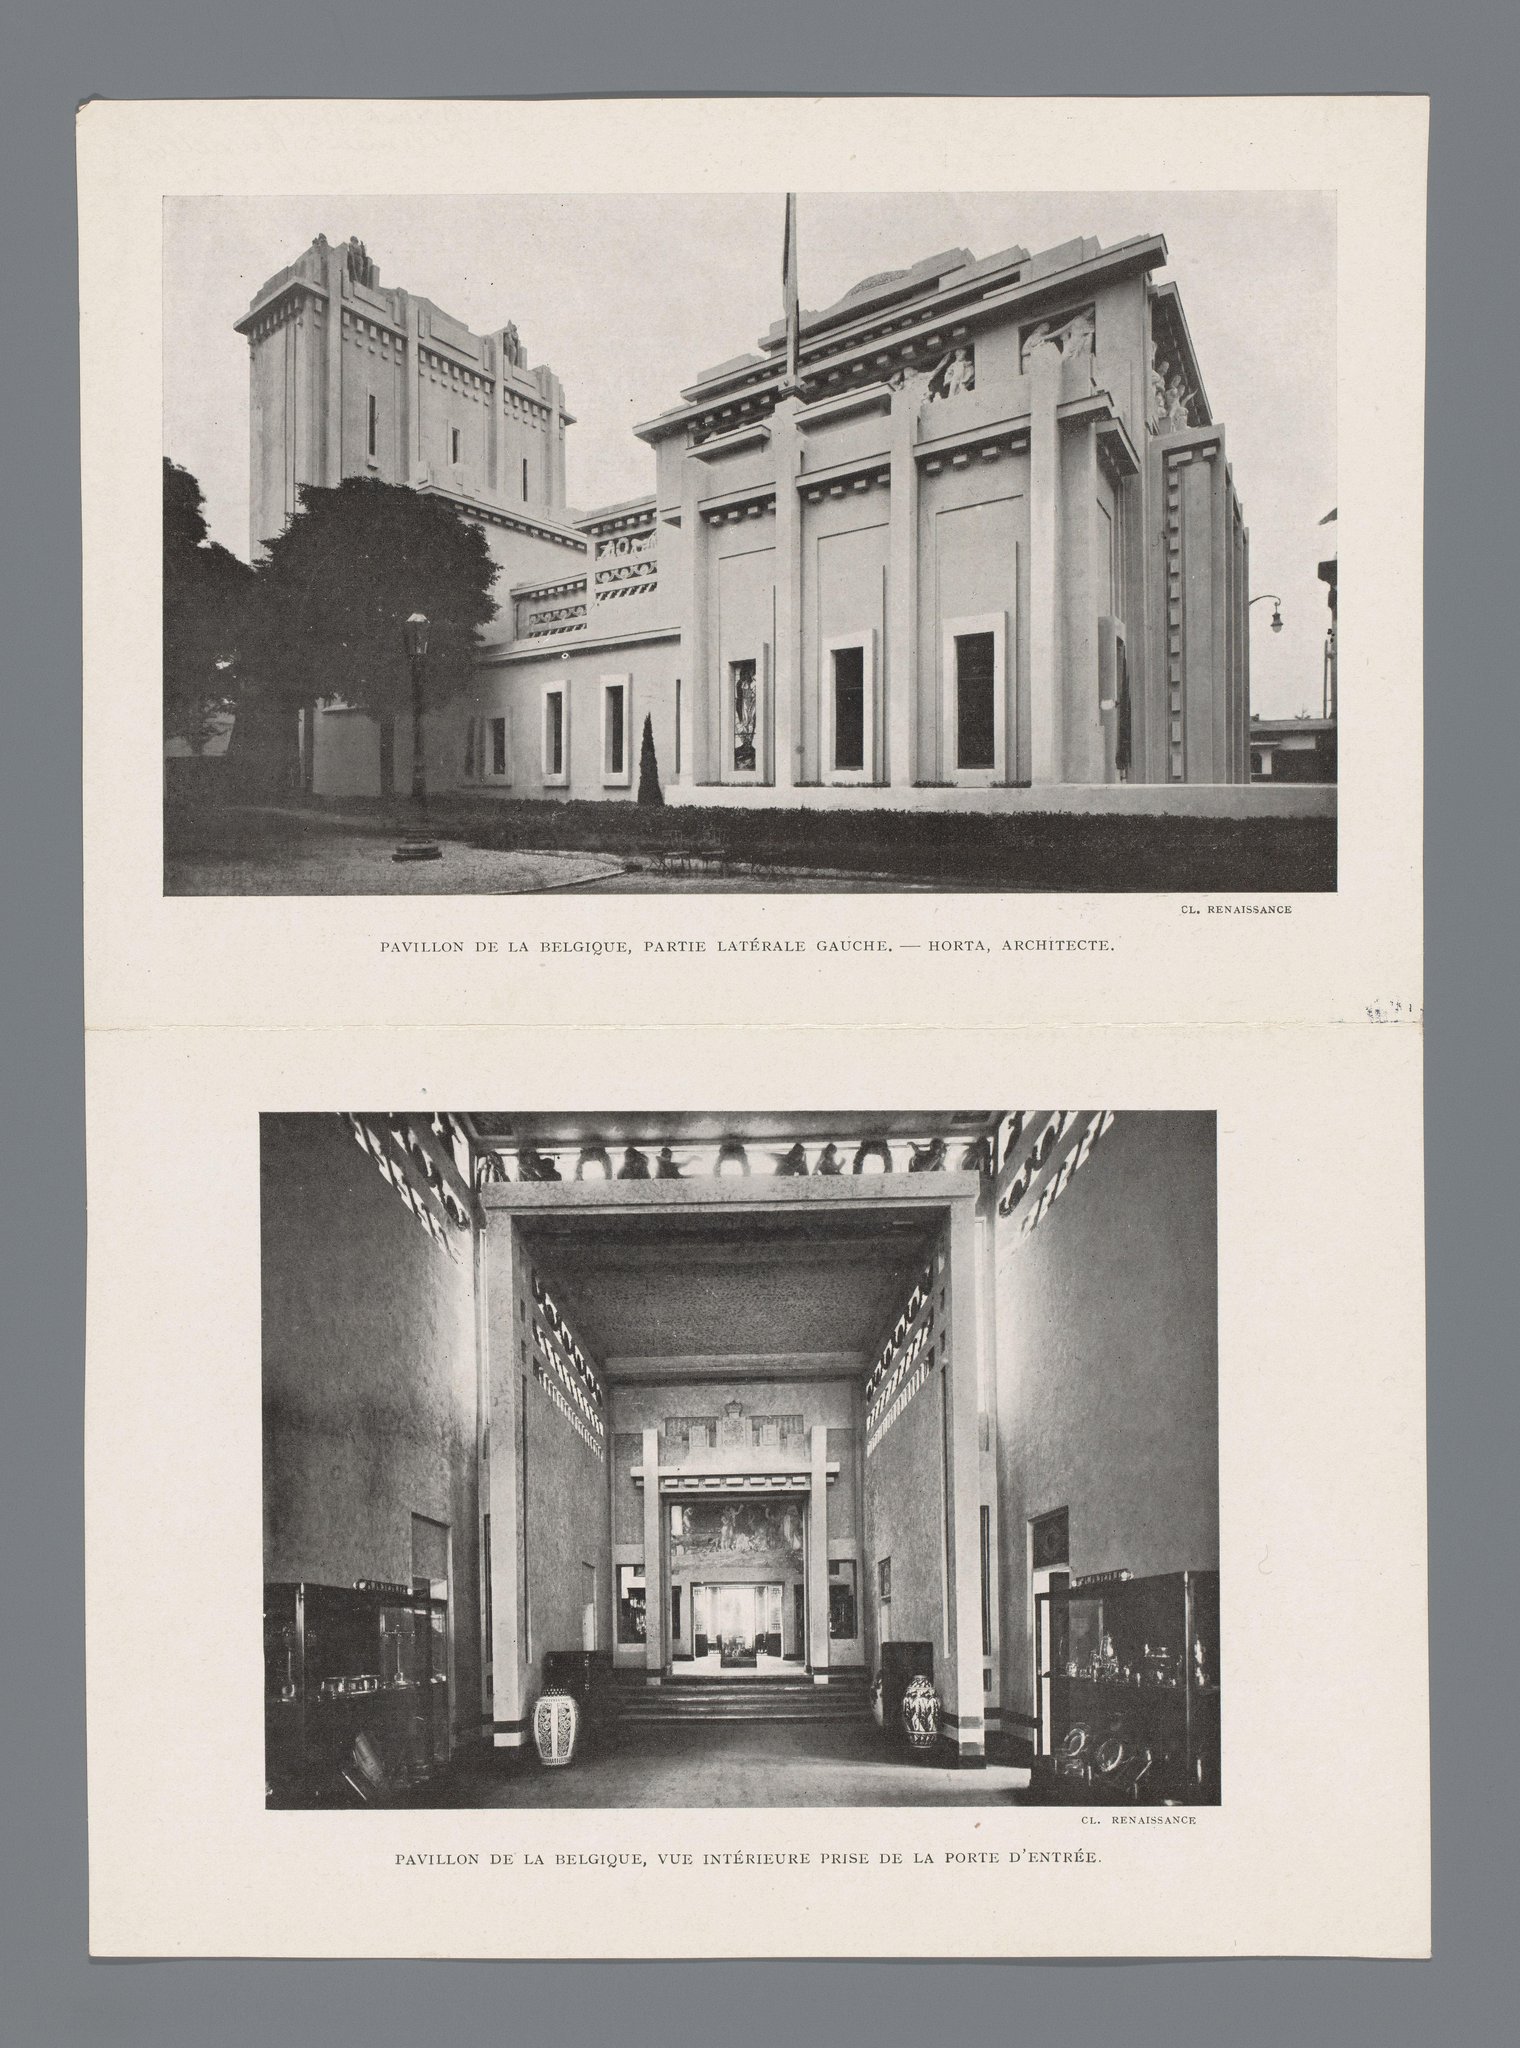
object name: photograph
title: Pavillon de la Belgique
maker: Anonymous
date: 1925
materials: photographic support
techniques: offset printed